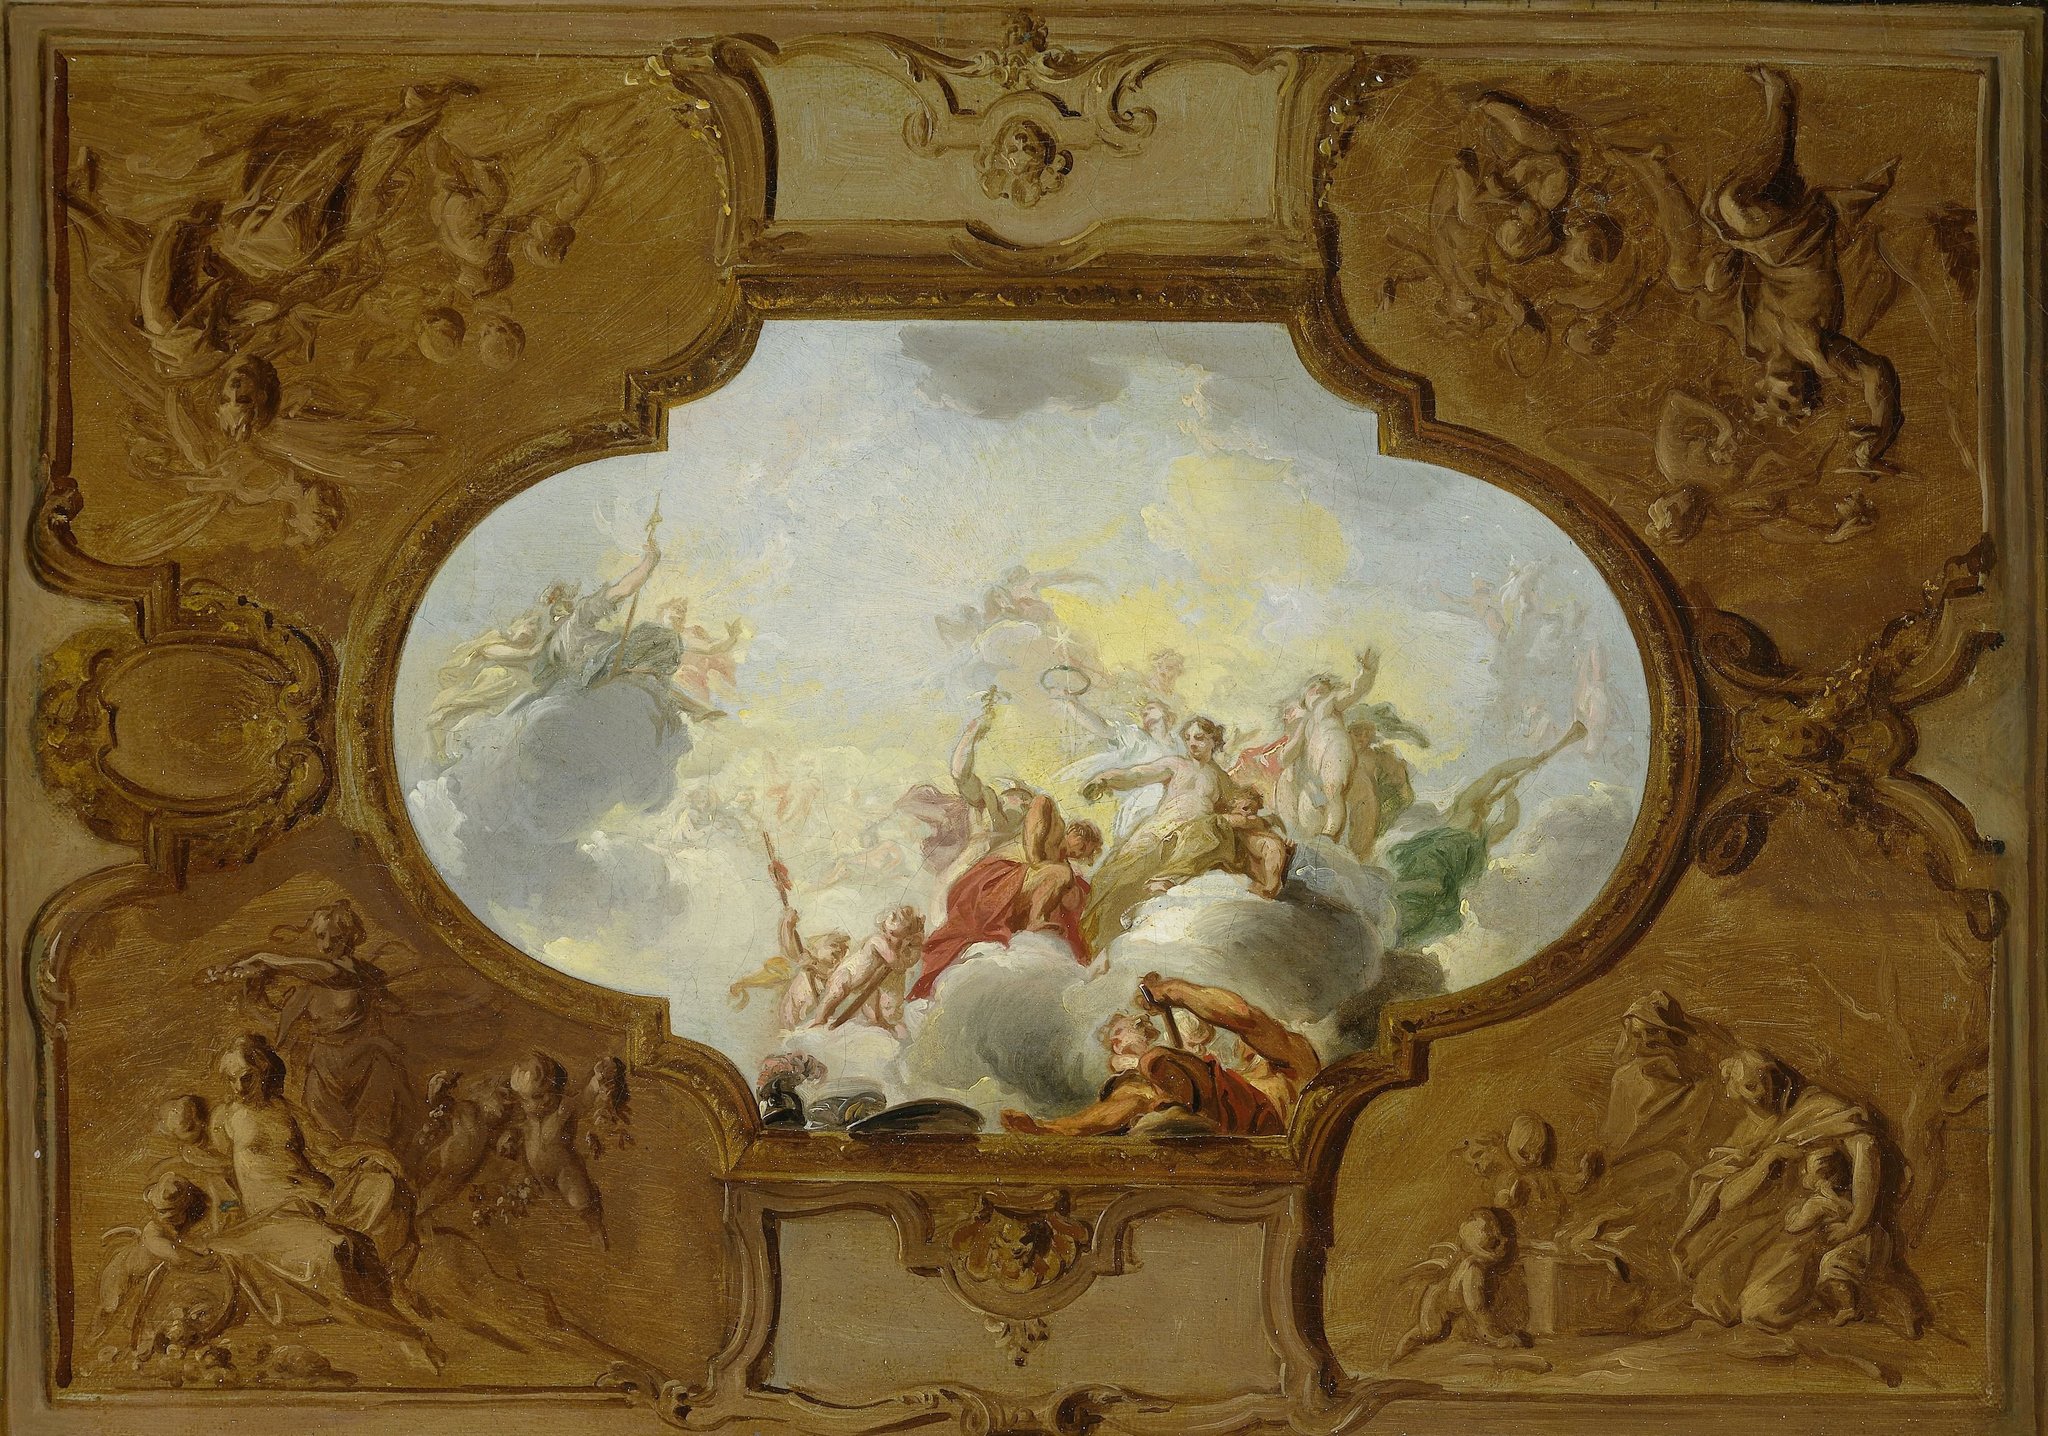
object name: painting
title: Design for a ceiling painting with the Apotheosis of Aeneas, in the corners the Four Seasons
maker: jacob de wit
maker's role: draughtsman, painter, print maker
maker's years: 1695-1754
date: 1720-1725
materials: canvas, oil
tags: year divided into four seasons, venus sprinkles and anoints aeneas' body with perfume and ambrosia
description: Ontwerp voor een plafondstuk met de apotheose van Aeneas. De held knielt in de wolken tussen de goden. In de hoeken worden de vier jaargetijden verbeeld door allegorische figuren en putti.